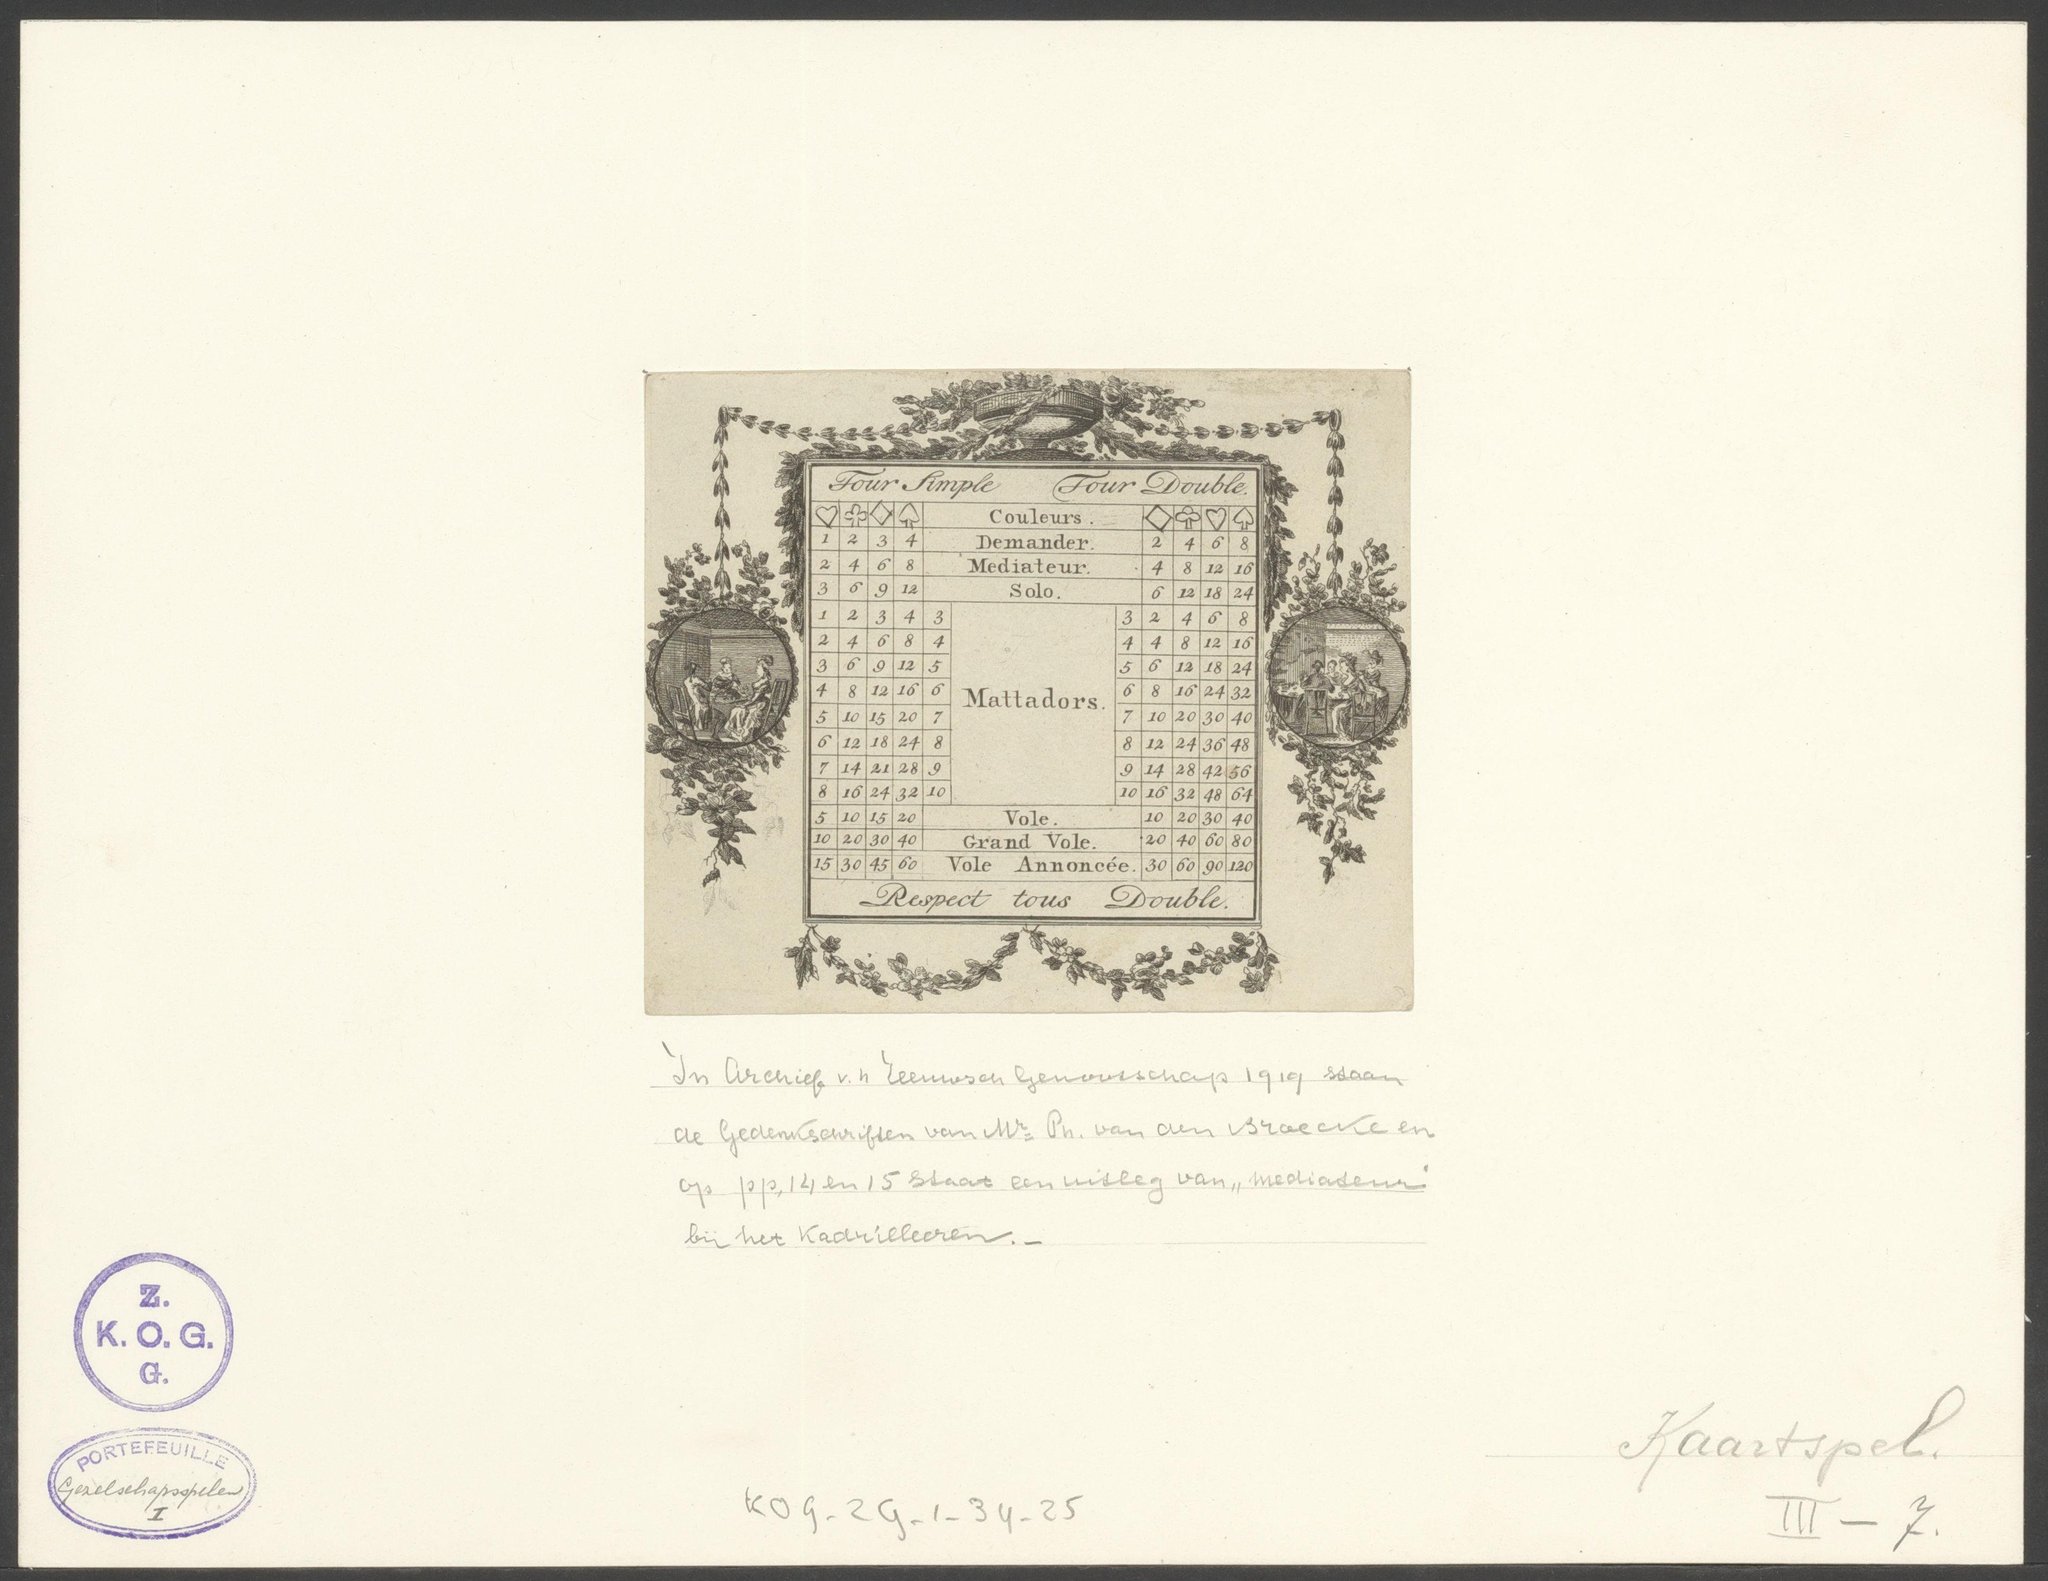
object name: print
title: Tabel behorende bij het hombre spel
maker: Anonymous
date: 1770-1800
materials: paper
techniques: etching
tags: card games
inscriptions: collector's mark, collector's mark: Lugt 1641